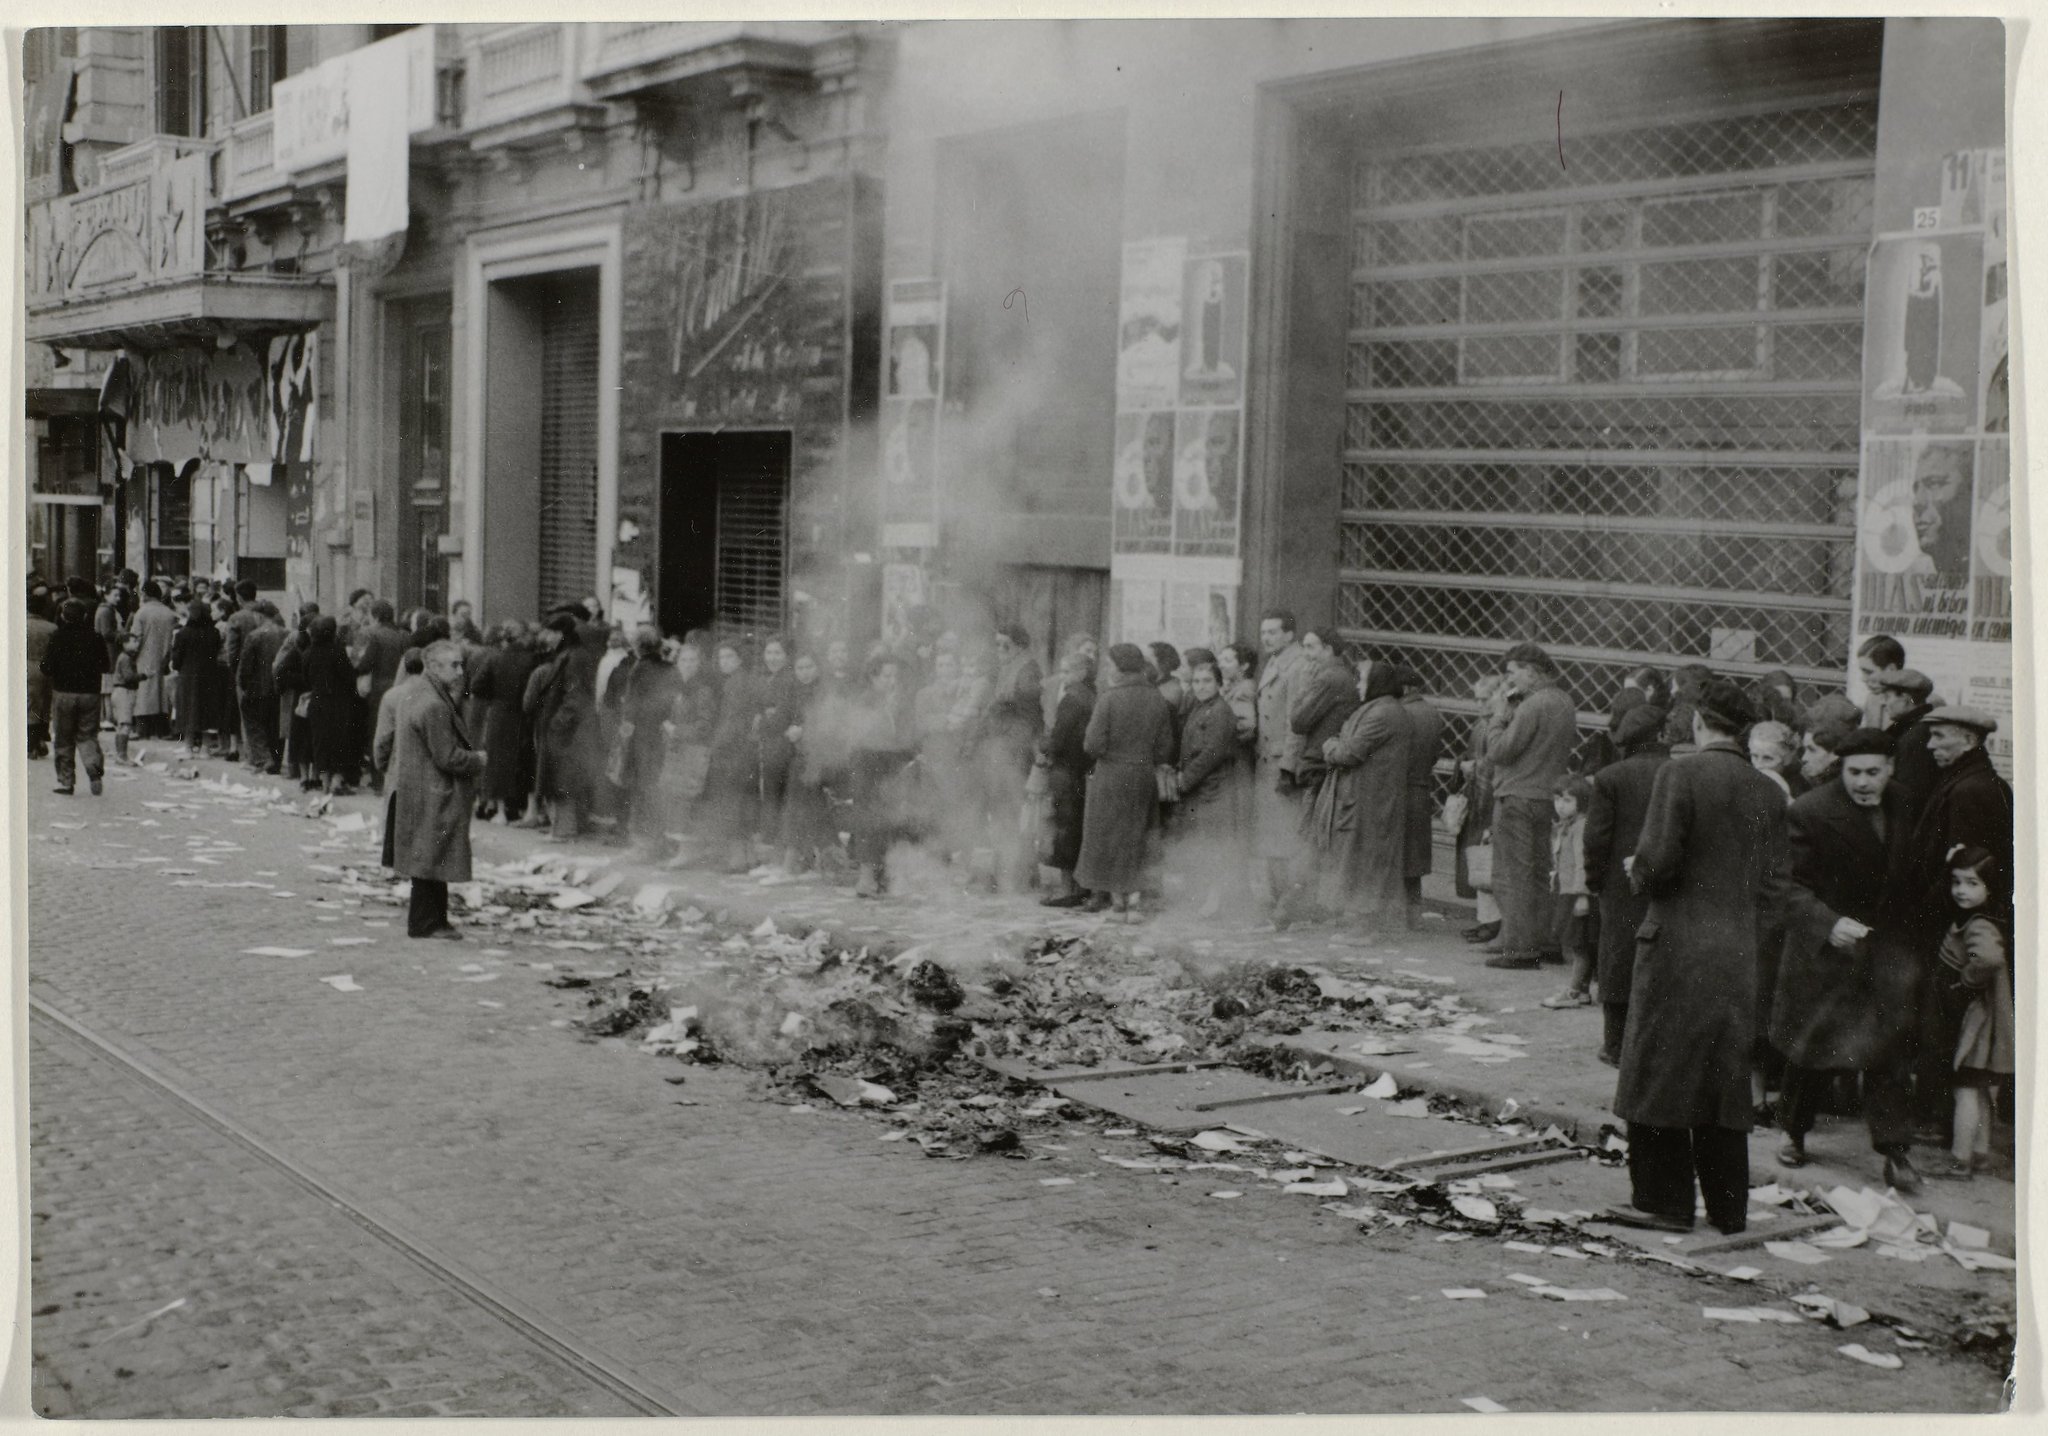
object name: photograph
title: In de rij voor voedsel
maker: Anonymous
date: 1939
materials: photographic support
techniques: gelatin silver print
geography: berlin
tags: barcelona, spaanse burgeroorlog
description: Rij op straat om een brood te bemachtigen, 29 januari 1939. Hongersnood in Barcelona na de verovering van de stad door de nationalistische troepen van Franco tijdens de Spaanse Burgeroorlog. Op de achterzijde twee stempels en blaadje met perstekst in het Duits.